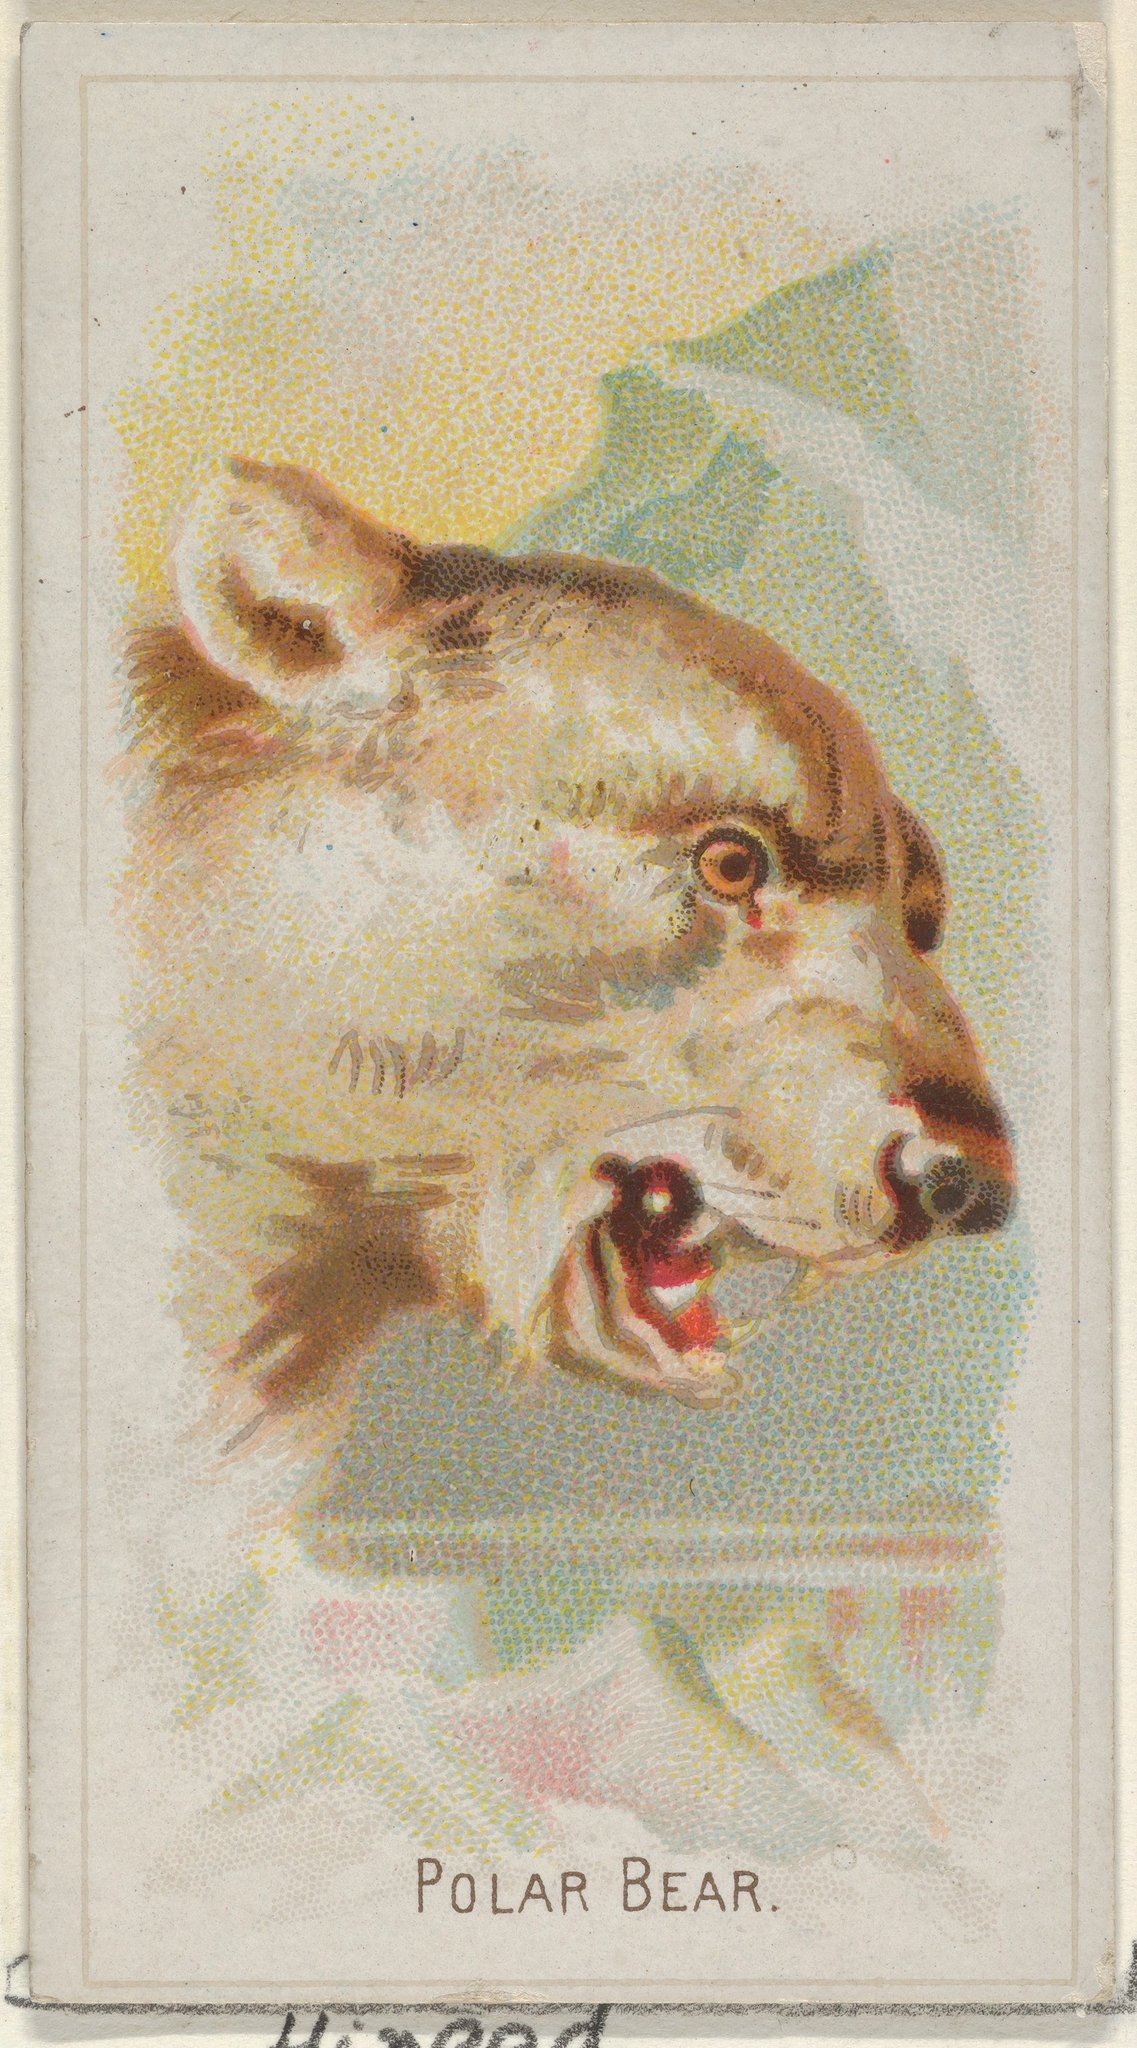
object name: print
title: Polar Bear, from the Wild Animals of the World series (N25) for Allen & Ginter Cigarettes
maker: allen & ginter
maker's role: publisher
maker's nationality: american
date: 1888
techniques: color lithograph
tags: bears